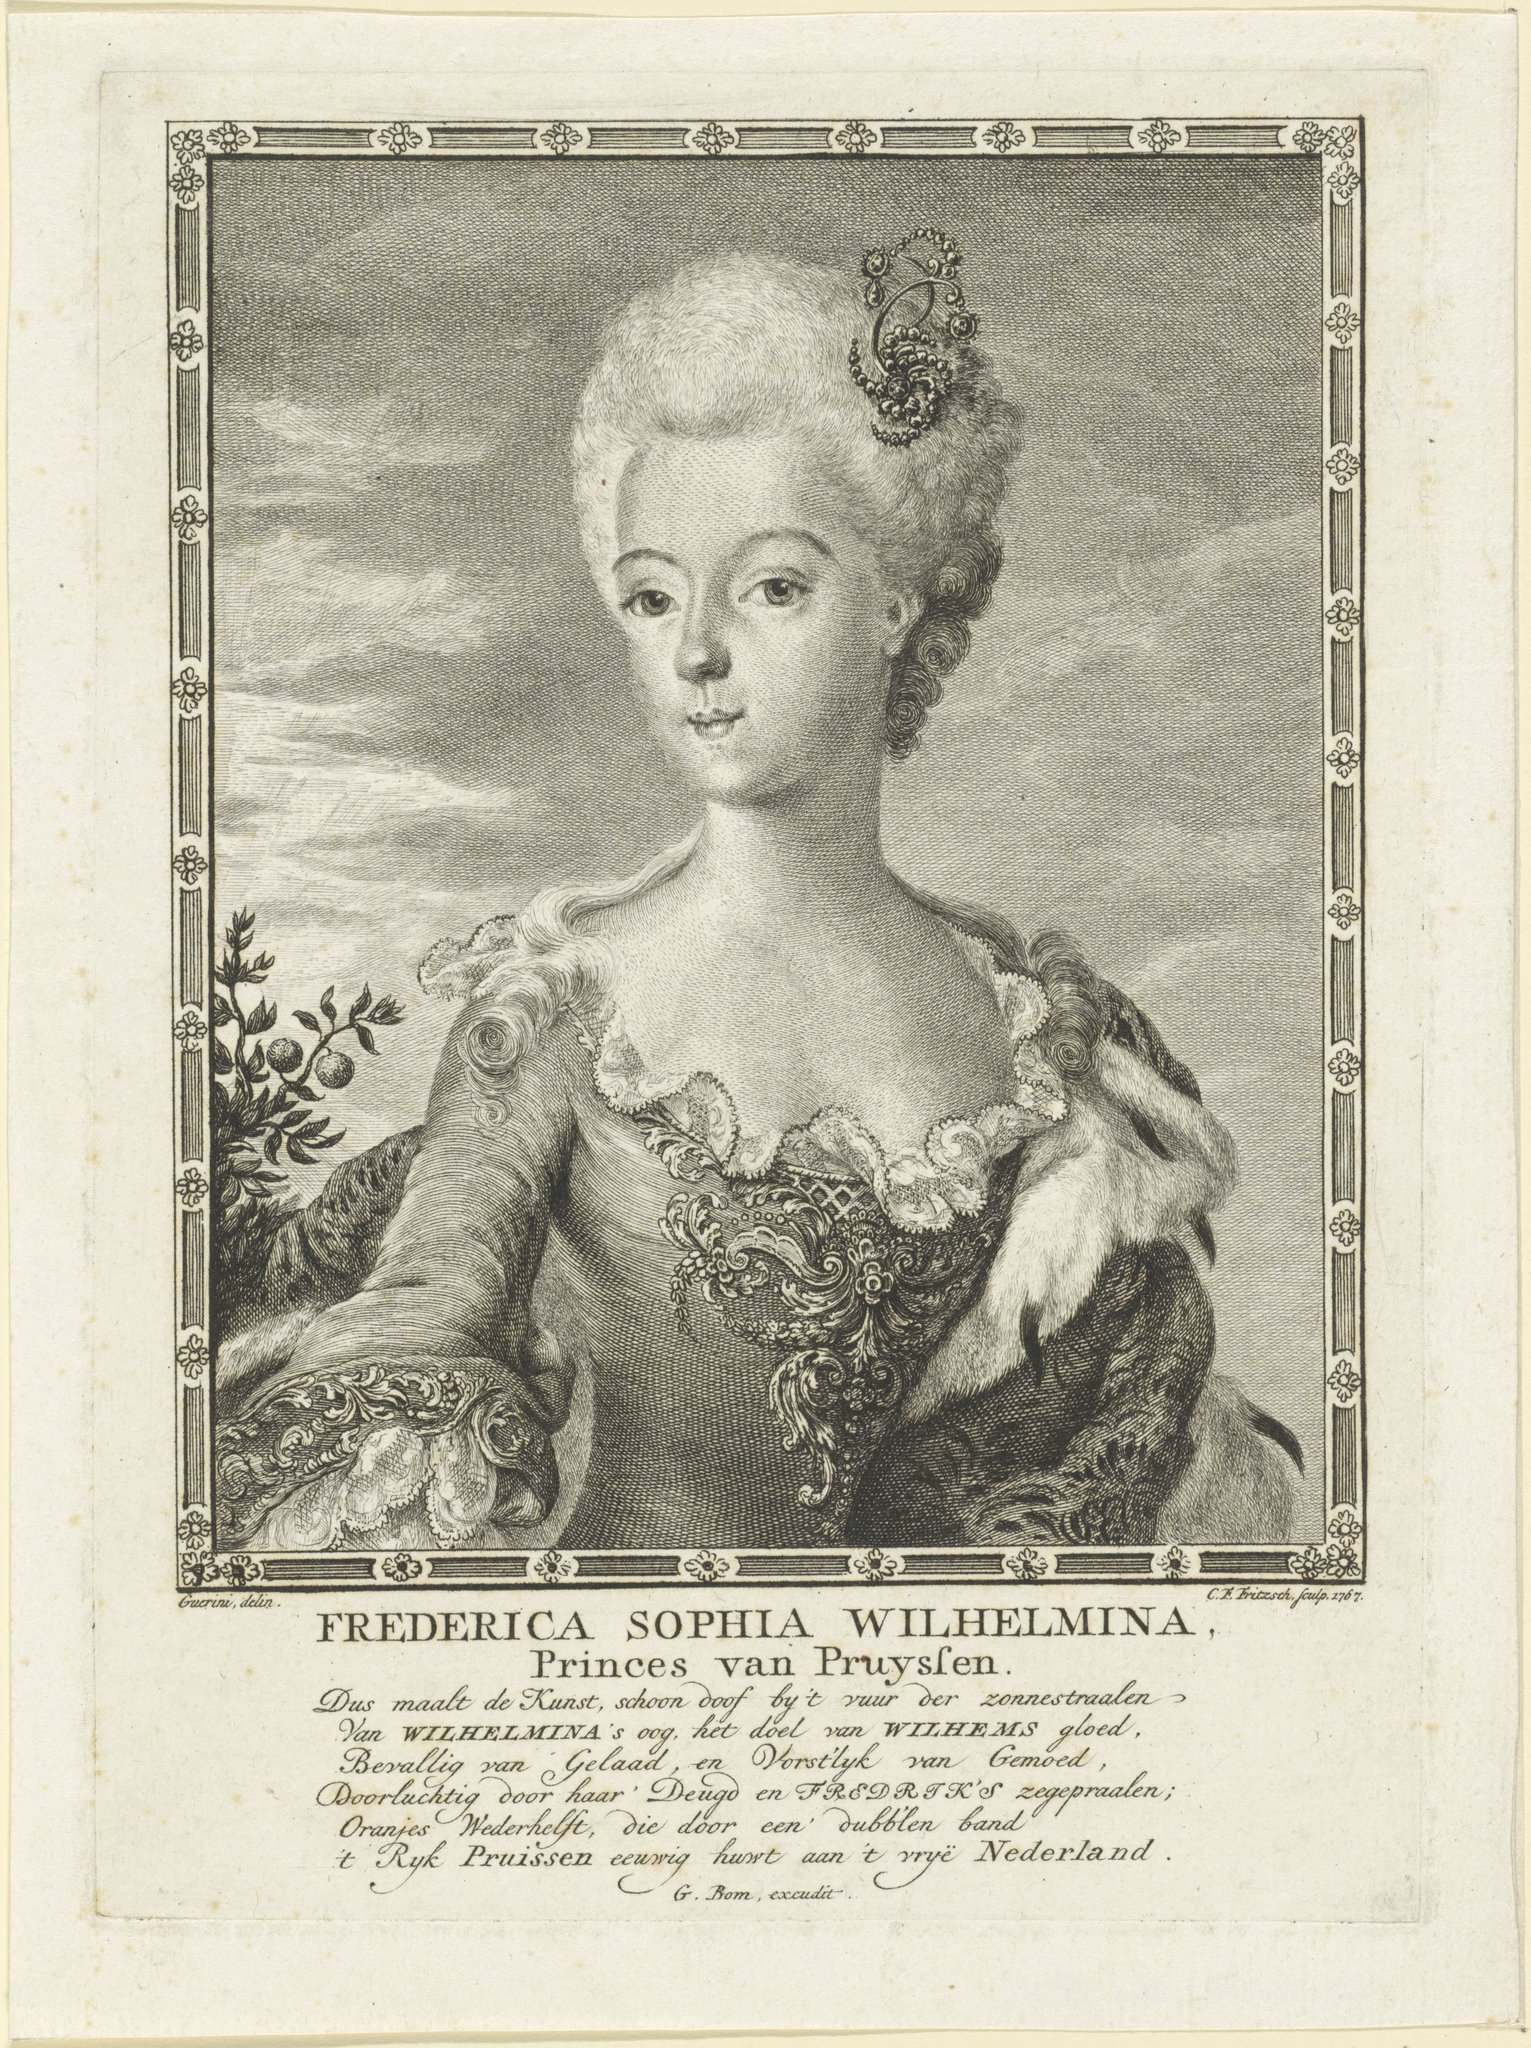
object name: print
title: Portret van Wilhelmina van Pruisen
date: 1767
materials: paper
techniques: engraving, etching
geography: amsterdam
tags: berlin, draughtsman, wilhelmina of prussia (princess of orange)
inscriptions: date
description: Portret van Wilhelmina. In de ondermarge haar naam, haar titel en zes regels Nederlandse tekst.